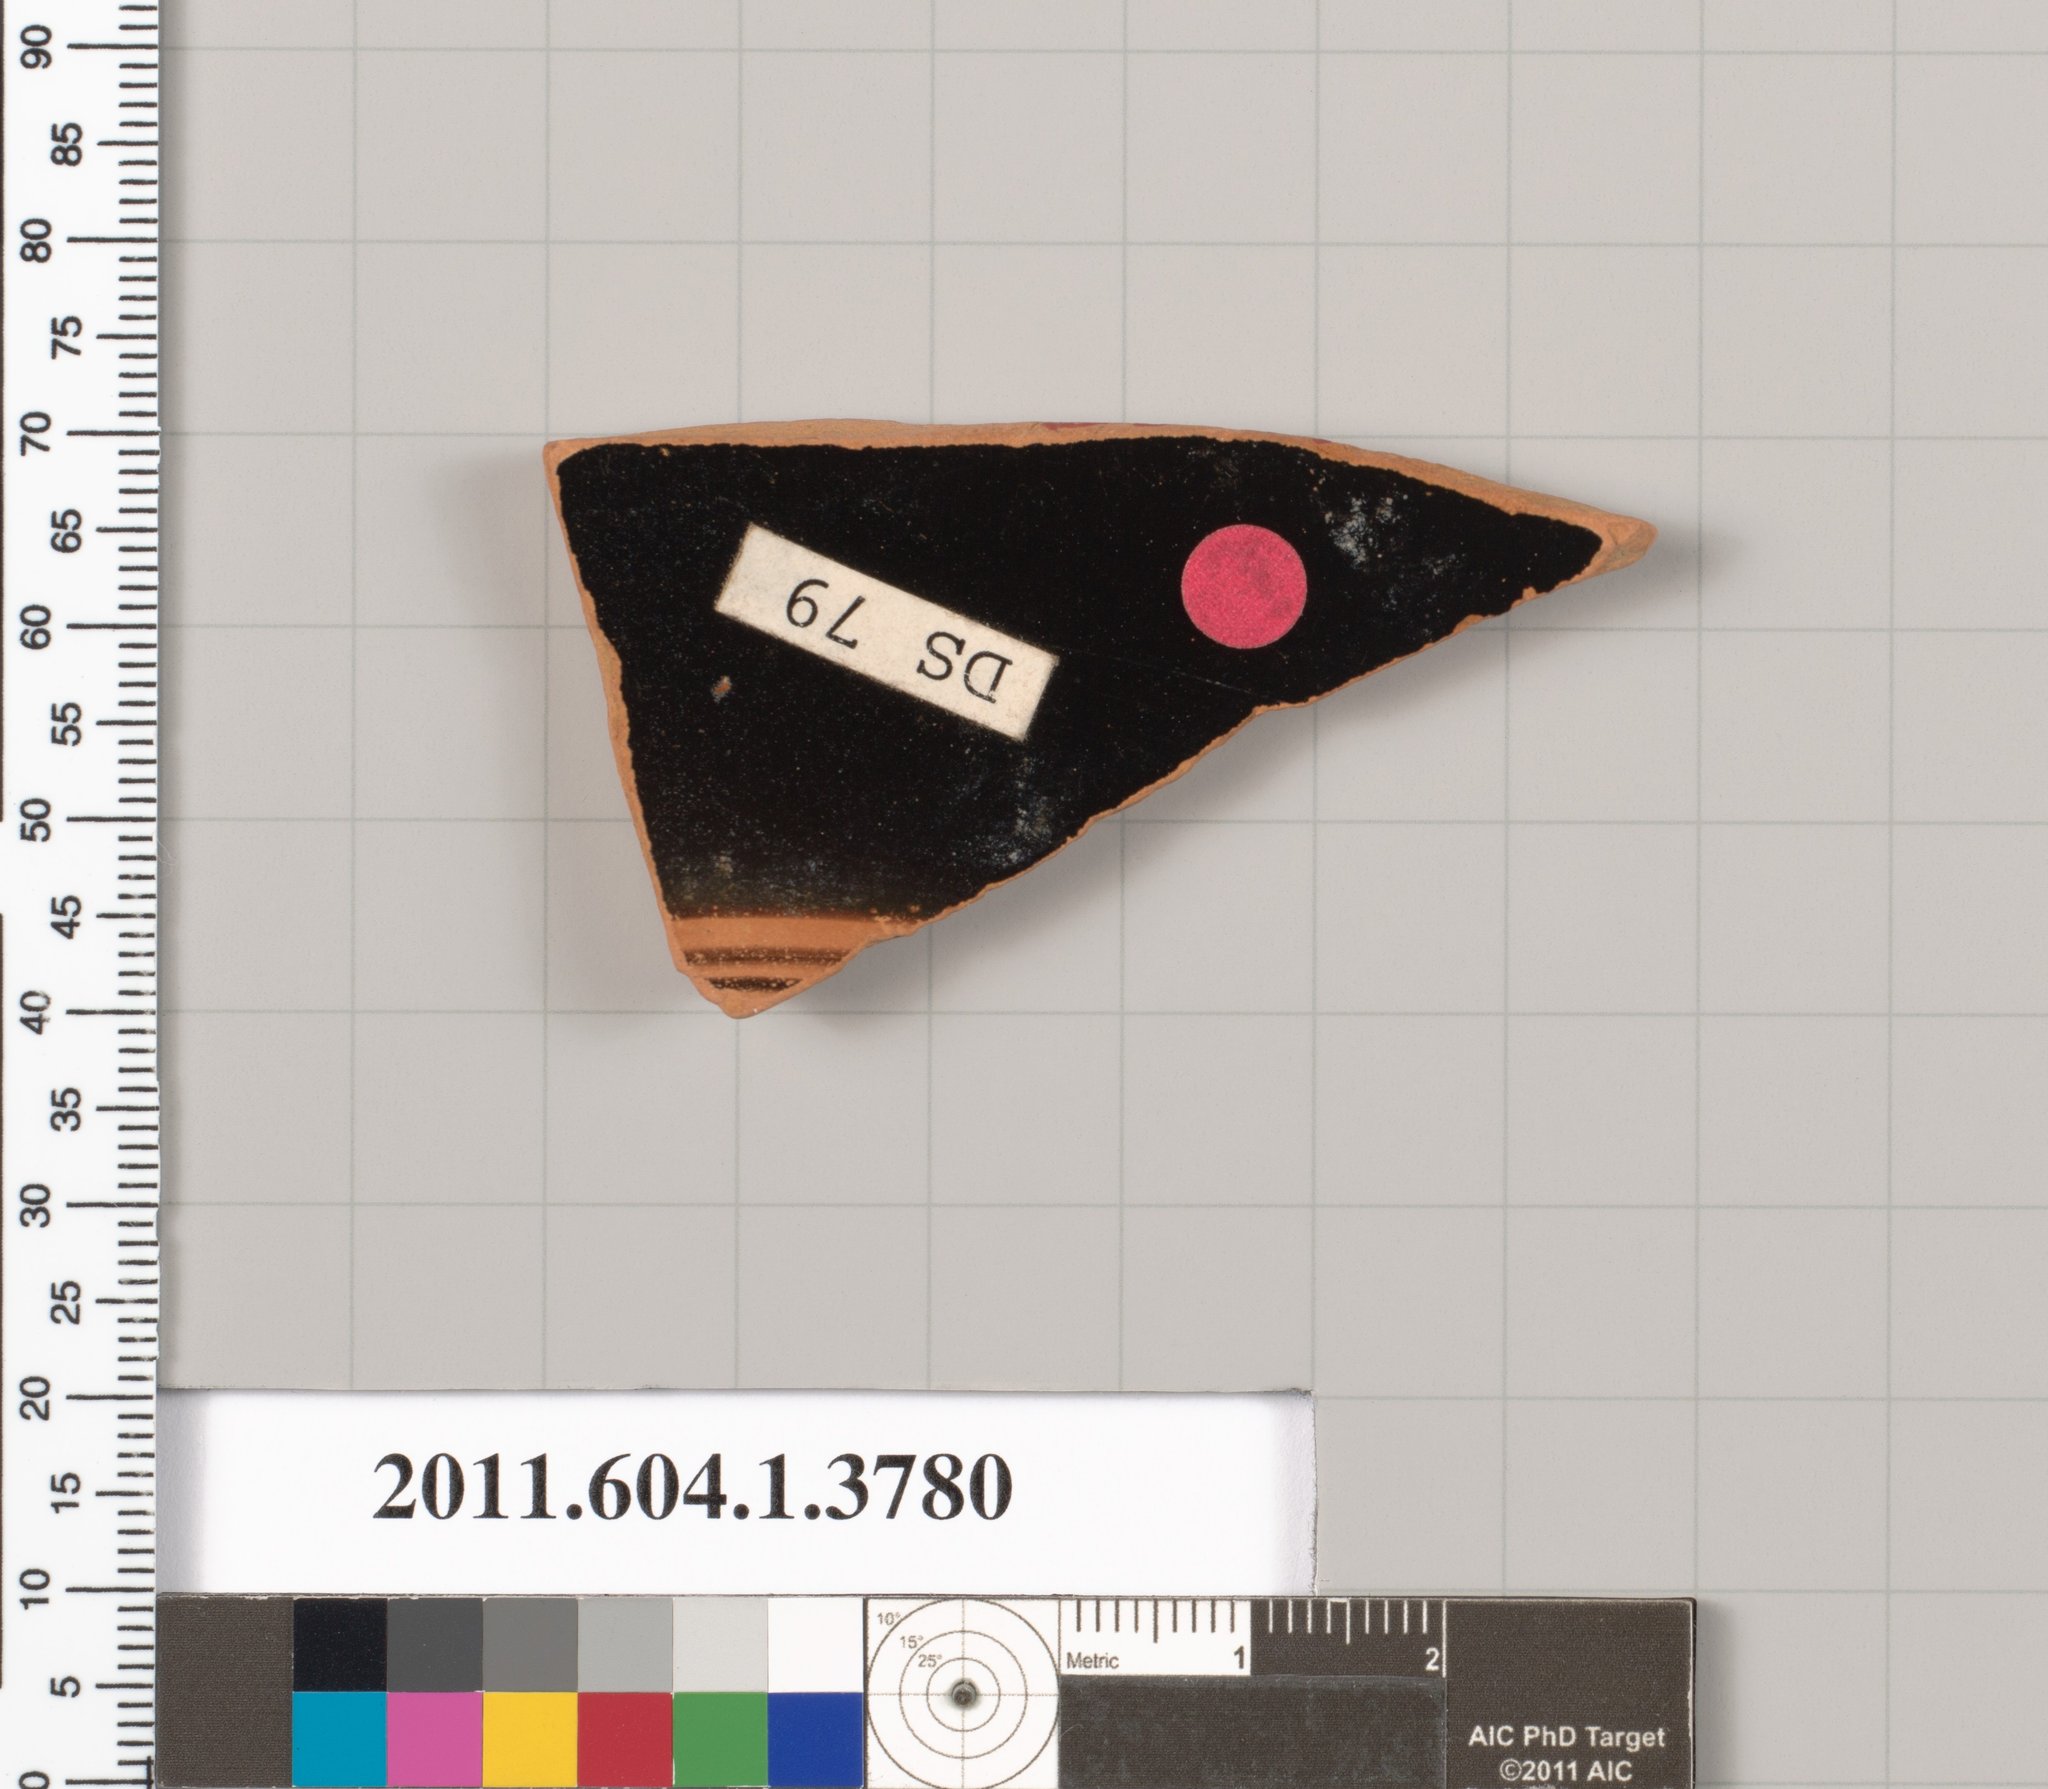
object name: kylix fragment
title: Terracotta fragment of a kylix (drinking cup)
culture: greek, attic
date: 475-451 BCE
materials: terracotta